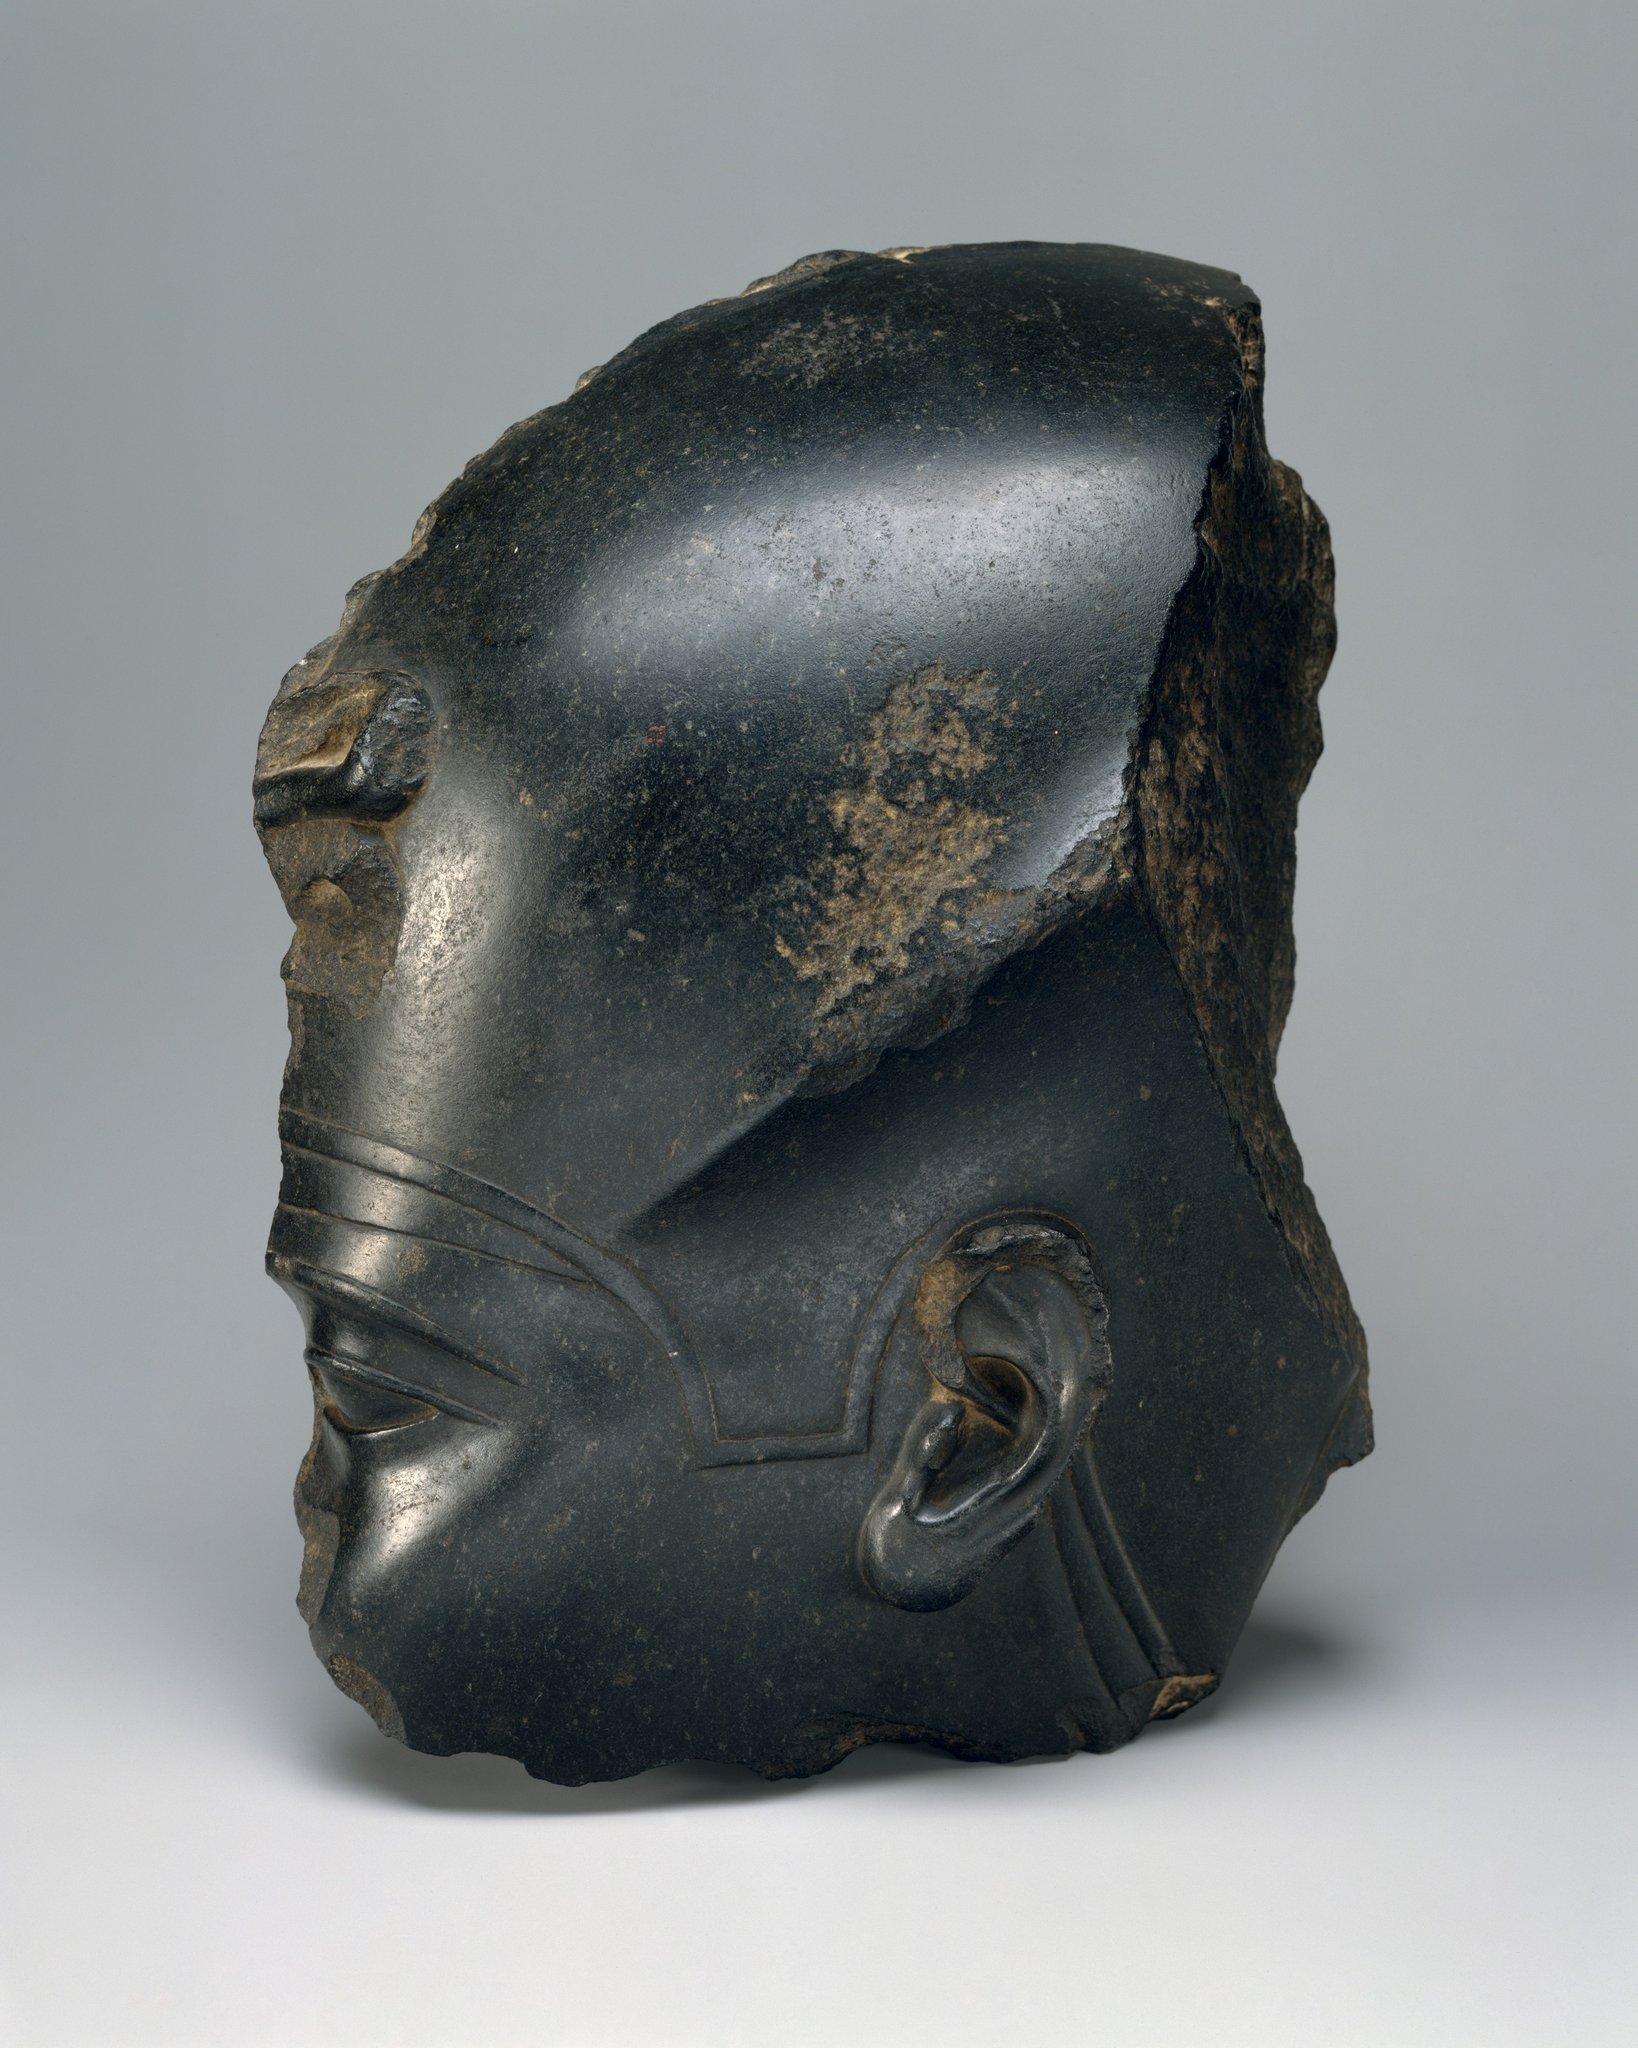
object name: head fragment, apries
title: Fragment of a Royal Head, Probably Apries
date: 589-570 BCE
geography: egypt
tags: heads